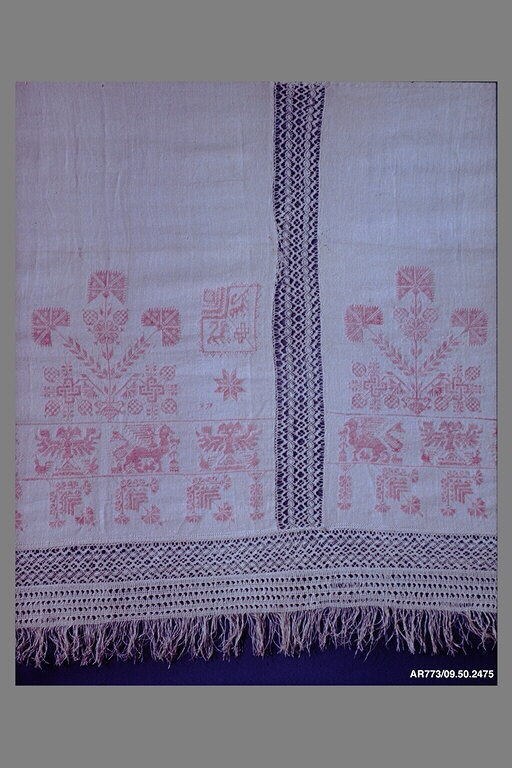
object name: bed valance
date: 1701-1800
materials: linen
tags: animals